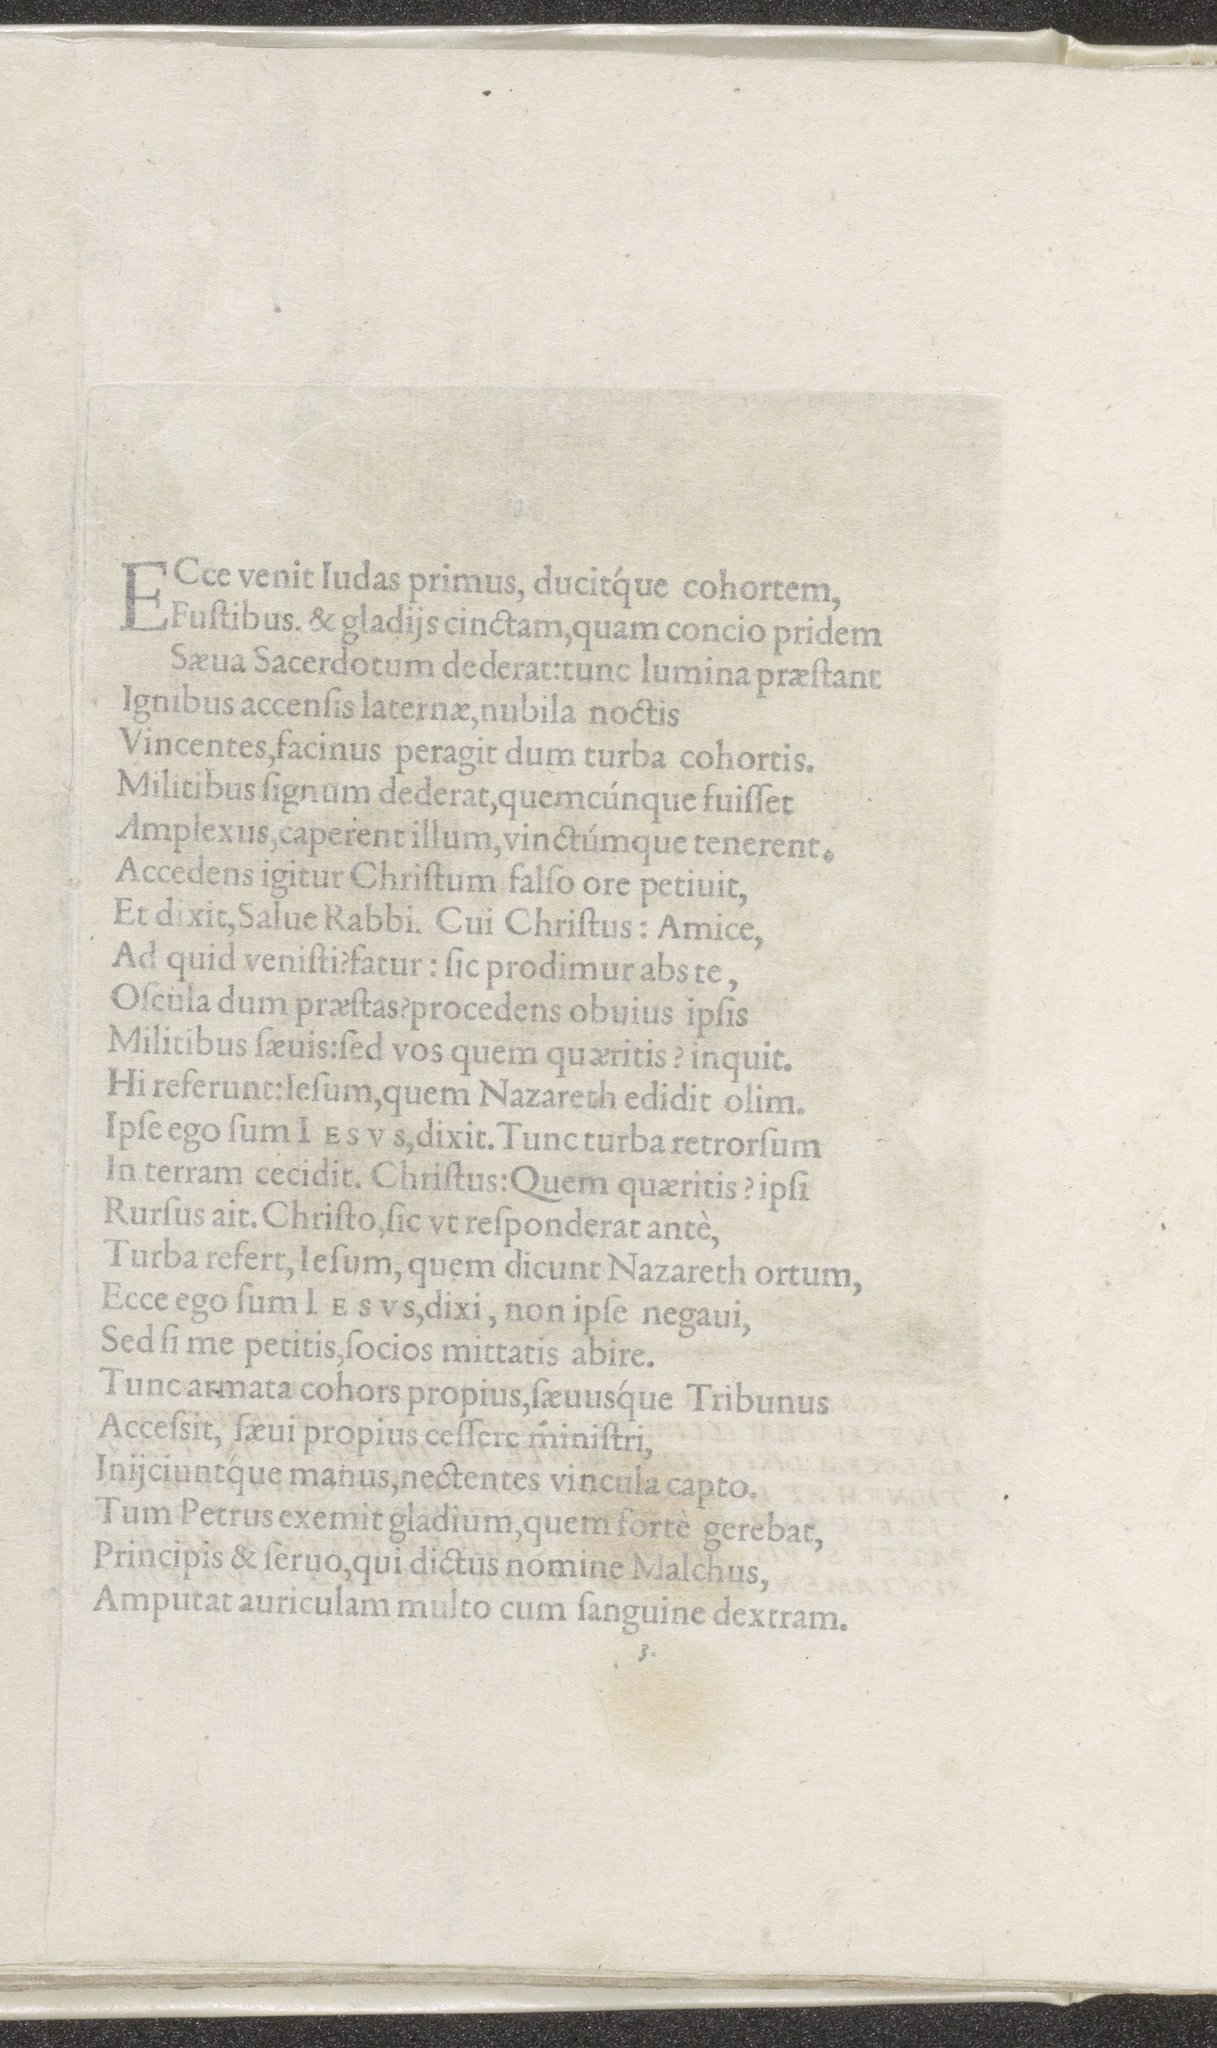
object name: album leaf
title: Tekst over de Judaskus en arrestatie van Christus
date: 1572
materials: paper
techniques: letterpress printing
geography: antwerp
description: Tijdens de restauratie in 1988 bleek dat op de achterzijde van de prenten van de Passie-serie van Wierix Latijnse teksten in boekdruk staan. Deze vormen, wanneer op de juiste wijze in boekvorm gebonden (wat nu in het Heemskerck-album niet het geval is), een toelichting op de passievoorstellingen. Om de teksten zichtbaar te laten zijn de prenten bij de restauratie niet meer met de achterzijde op elkaar geplakt.